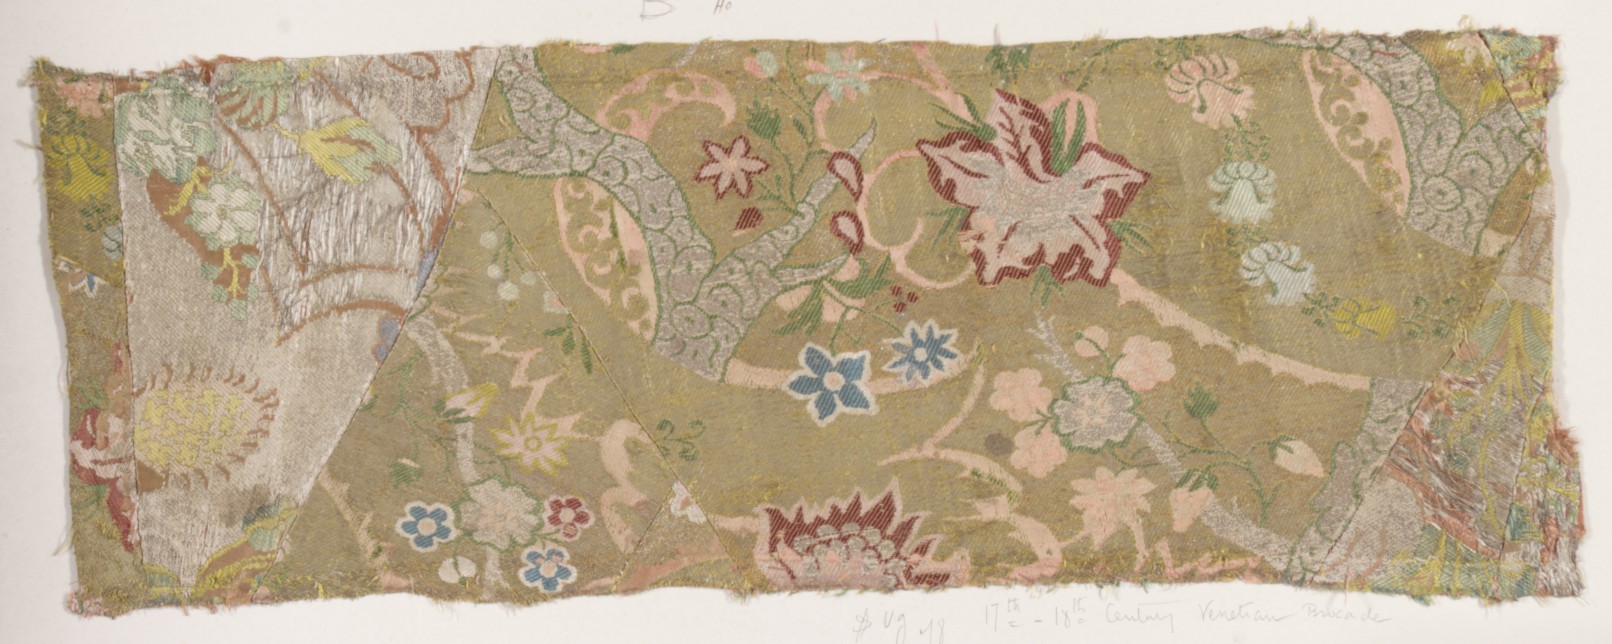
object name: fragment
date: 1701-1800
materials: metal thread, silk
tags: flowers,leaves